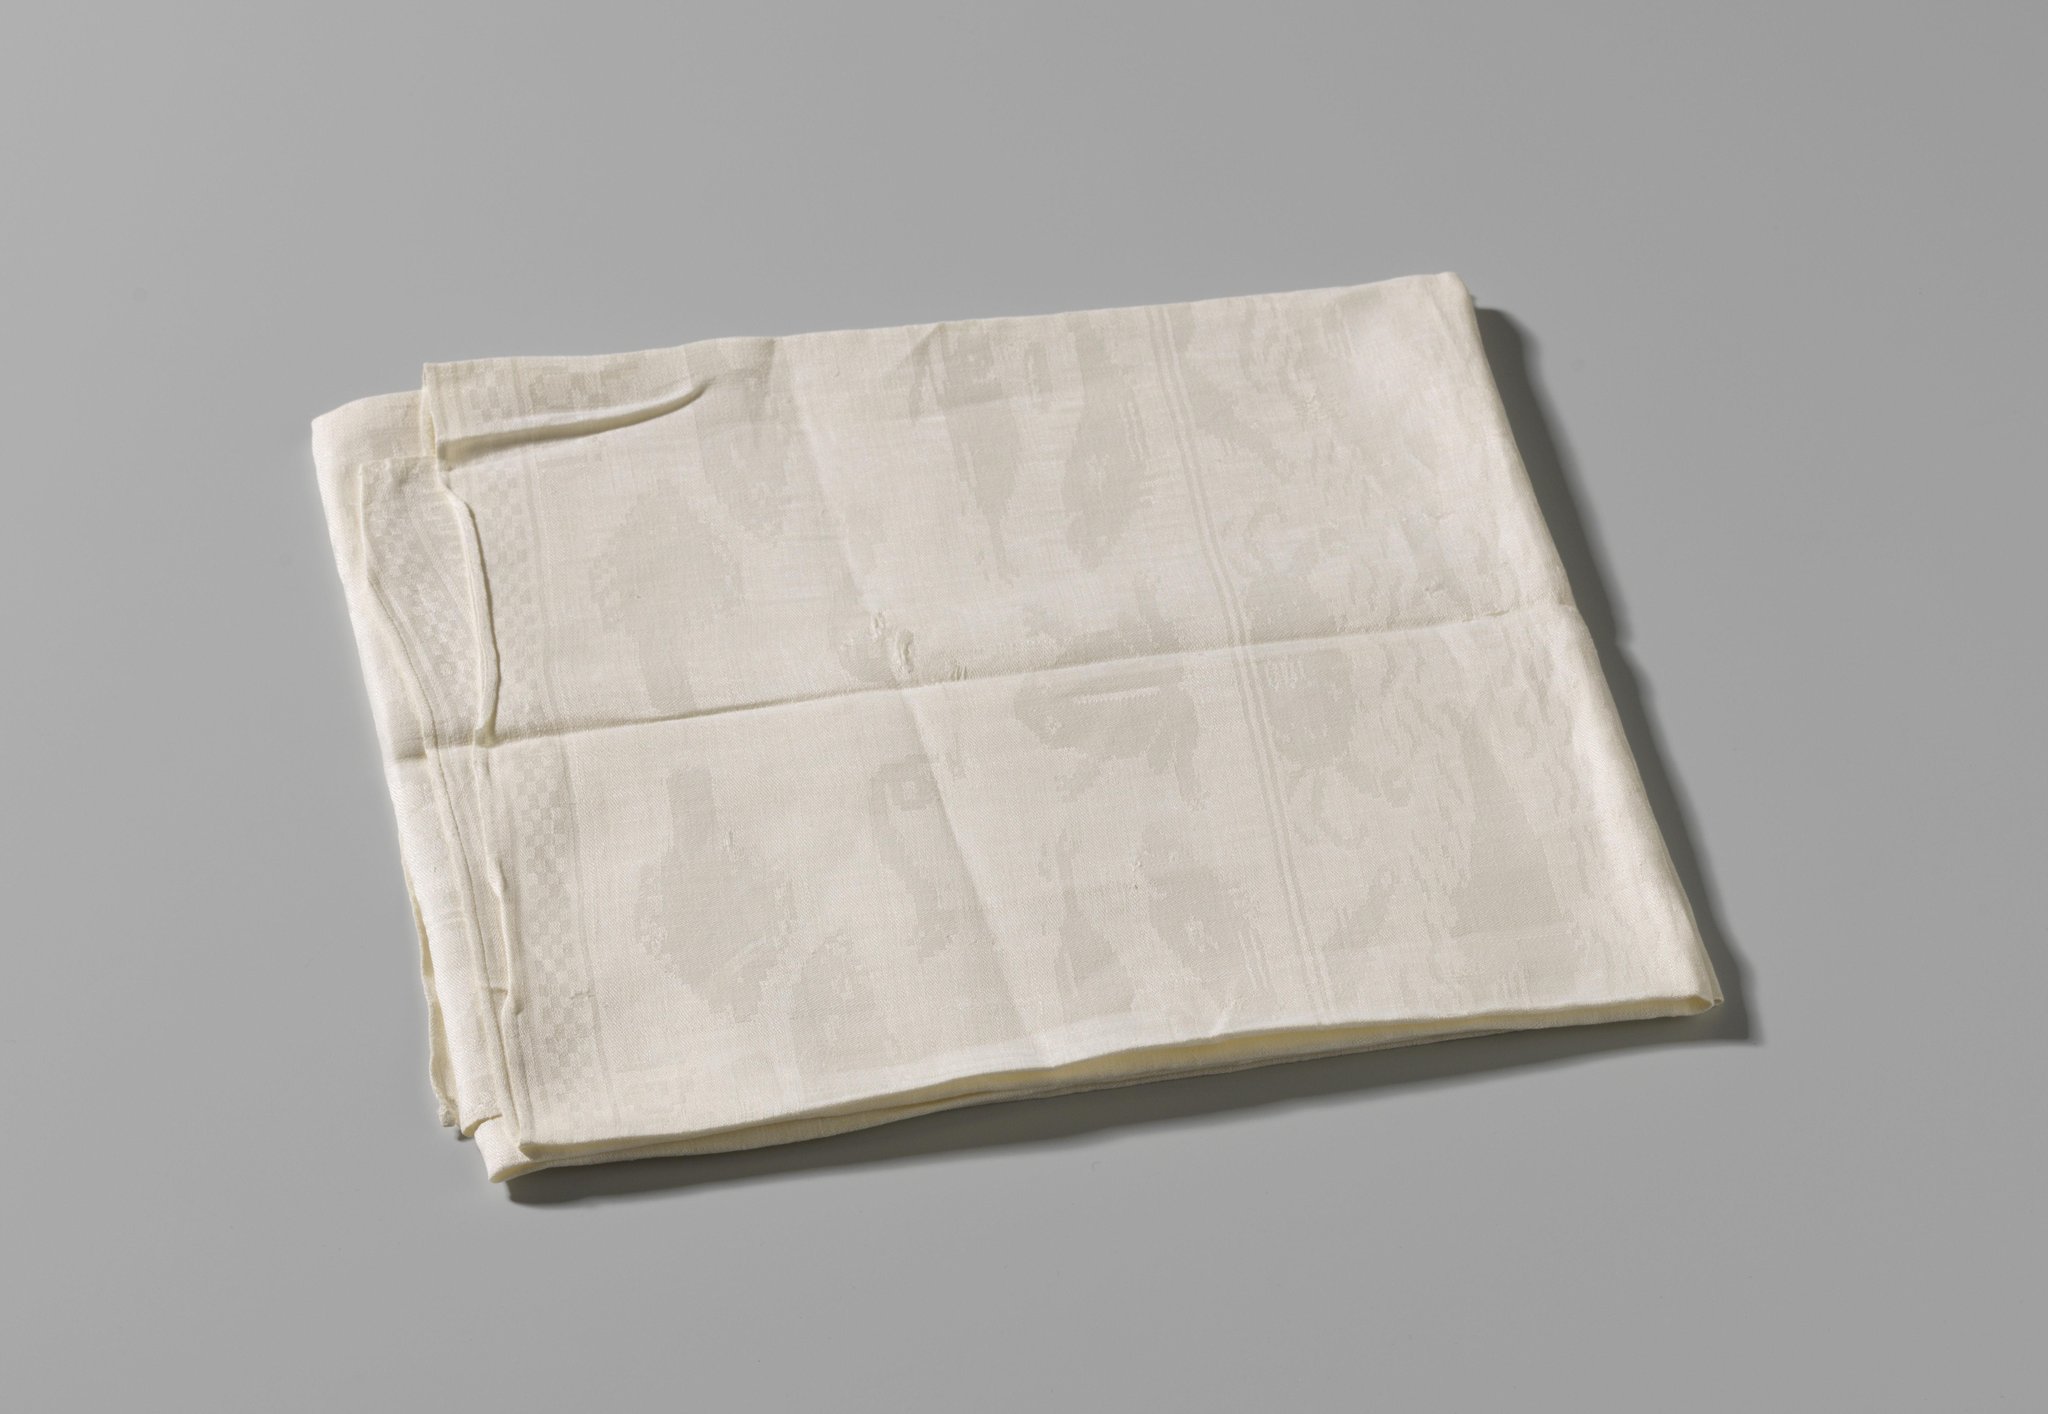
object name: napkin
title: Servet met schepen, vissen en de wapens van Scipio Meckama van Aijlva en Lucia van Eysinga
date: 1661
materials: linen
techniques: damask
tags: lucia van eysinga, scipio meckama van aijlva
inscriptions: mark: ‘L.V.A. 1661’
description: Servet van linnendamast met schepen, vissen en de wapens van Scipio Meckama van Aijlva en Lucia van Eysinga. Middenveld: het symmetrisch patroon vertoont: twee schepen, dolfijnen, zeemeerminnen, zeepaarden en diverse vissen. Staande randen: vis- en schaaldieren. In de brede liggende randen: een tak met bloemen, waaronder twee wapens met de onderschriften SCIPIO MECKAMA VAN ALVA en LUCIA VAN EYSINGA ANO 1661. In de hoeken geborduurd L.V.A. 1661.